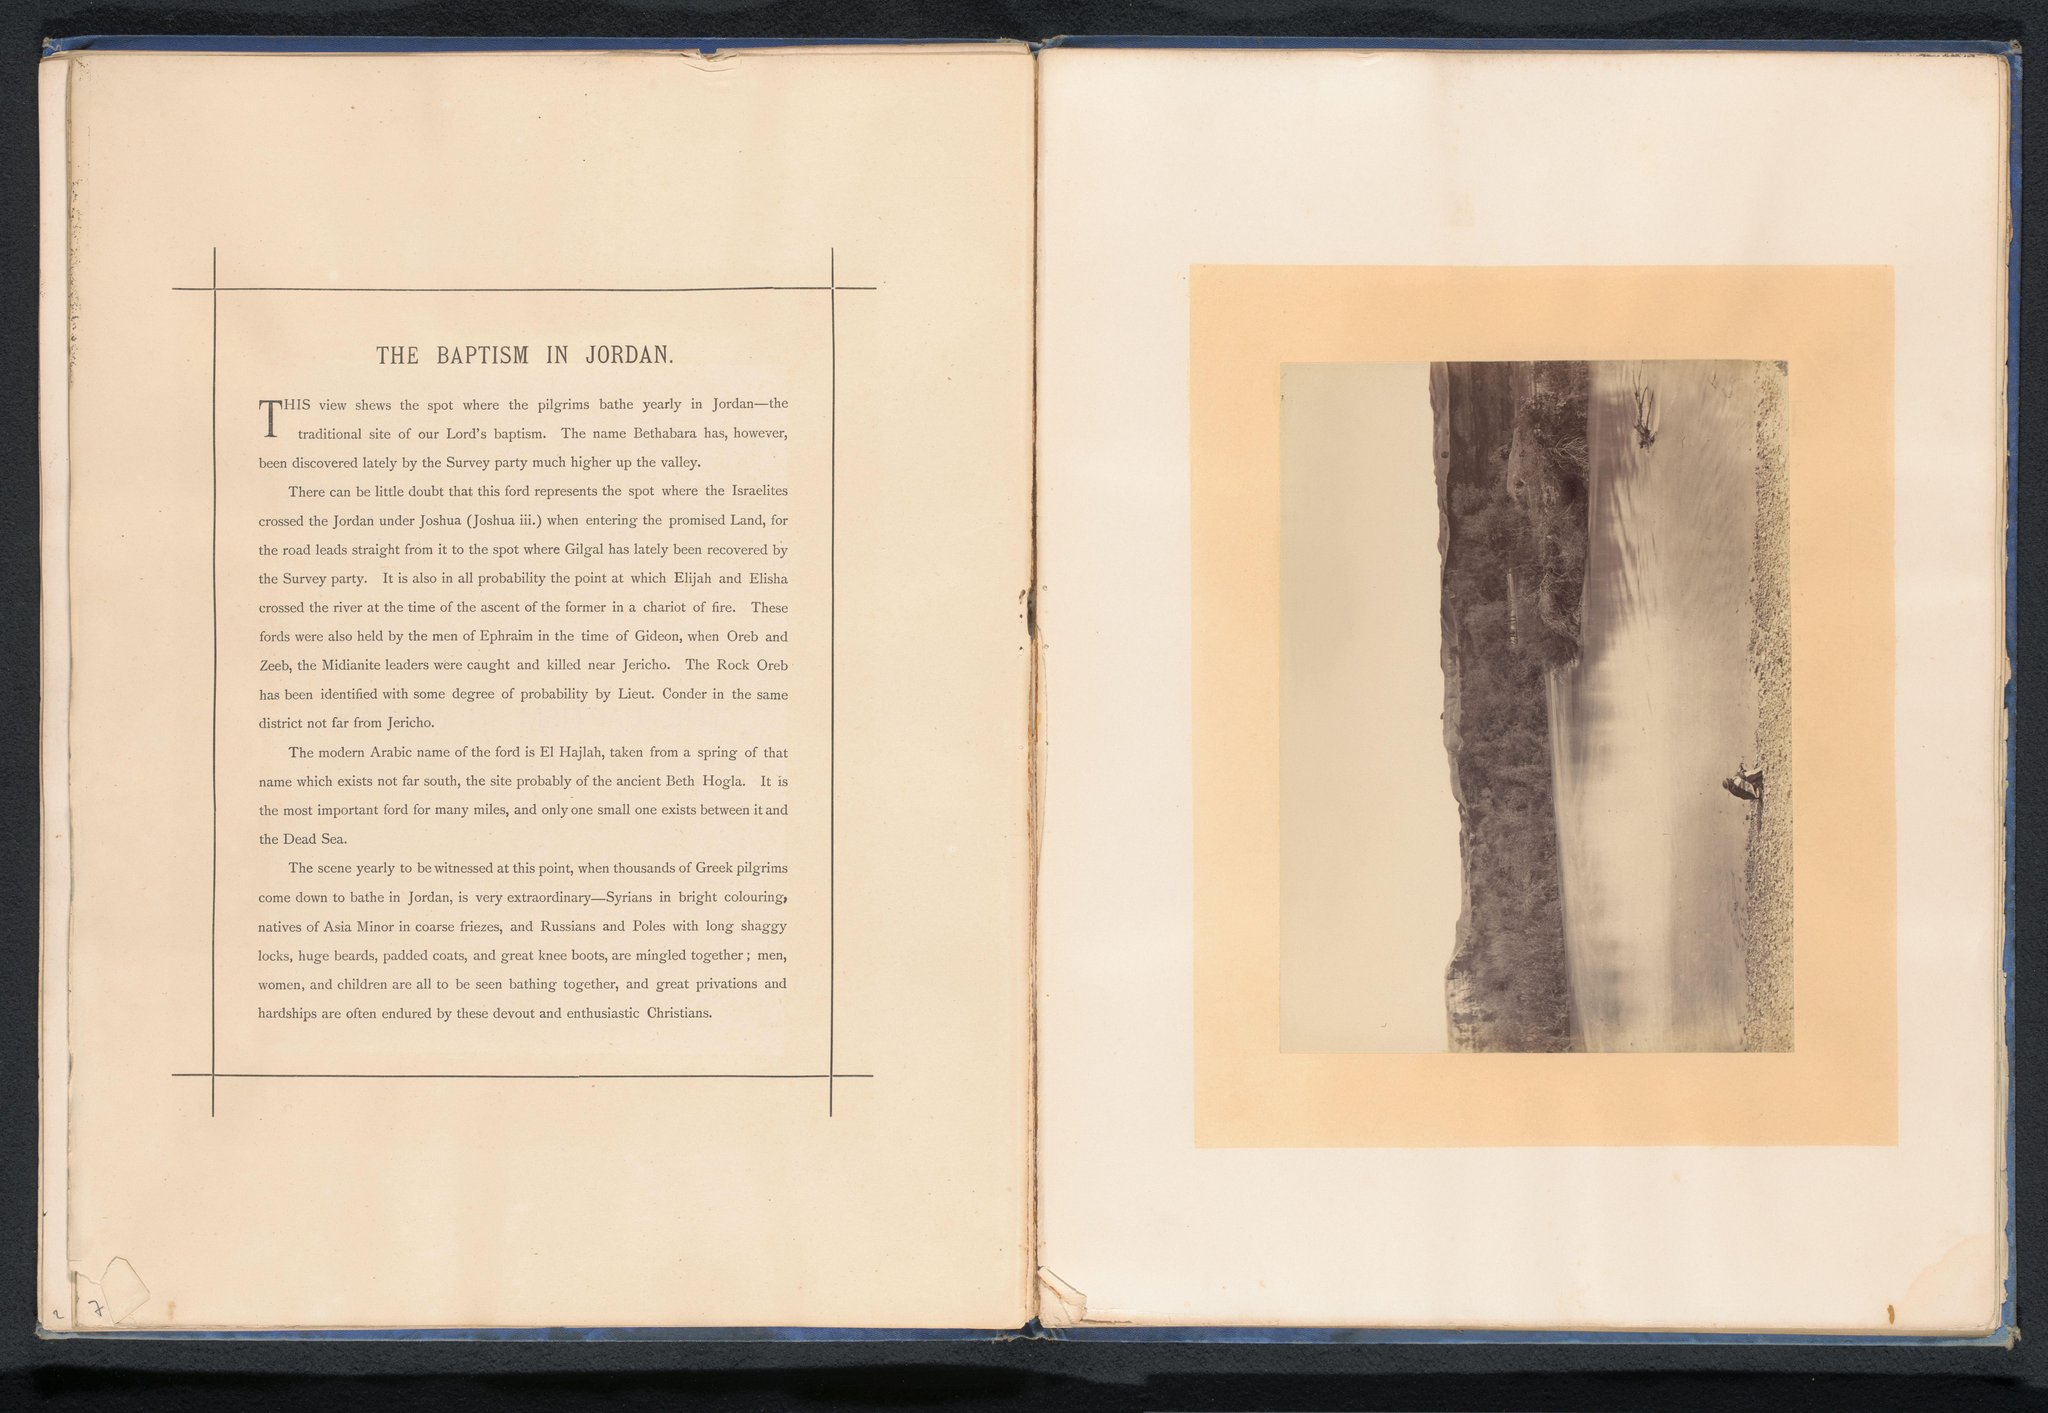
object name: photograph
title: Gezicht op de Jordaan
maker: horatio herbert kitchener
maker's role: fotograaf, luitenant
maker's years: 1850-1916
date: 1870-1875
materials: photographic support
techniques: albumen print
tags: river (+ landscape with figures, staffage)